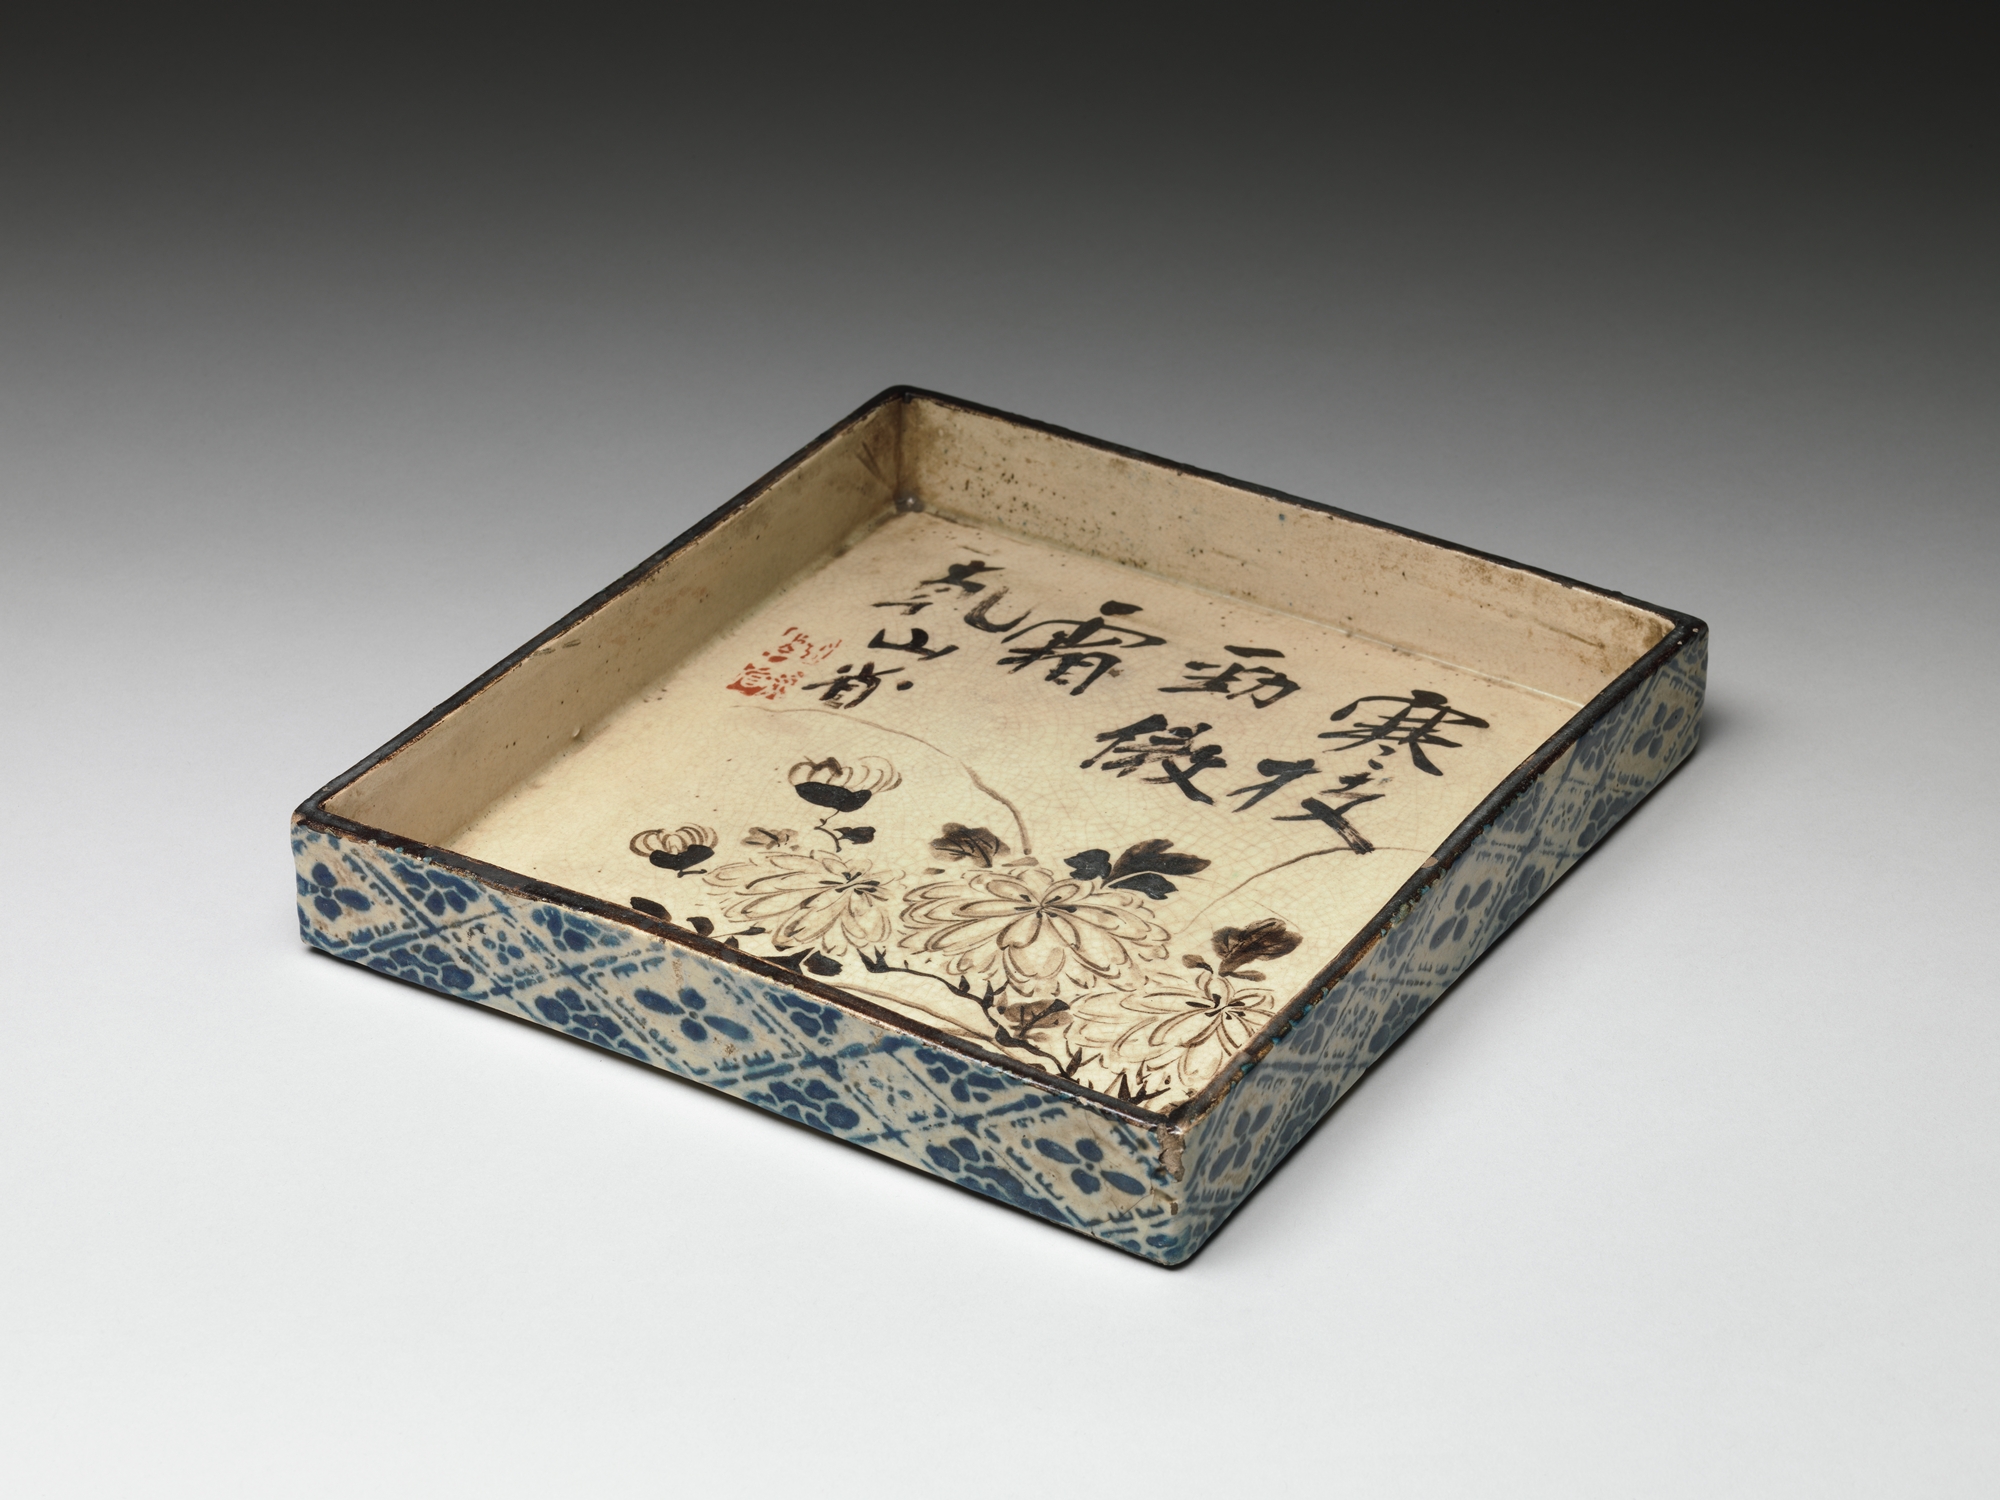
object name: tray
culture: japanese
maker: ogata kenzan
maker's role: artist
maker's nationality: japanese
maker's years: 1663-1743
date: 1720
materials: clay, glaze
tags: flowers